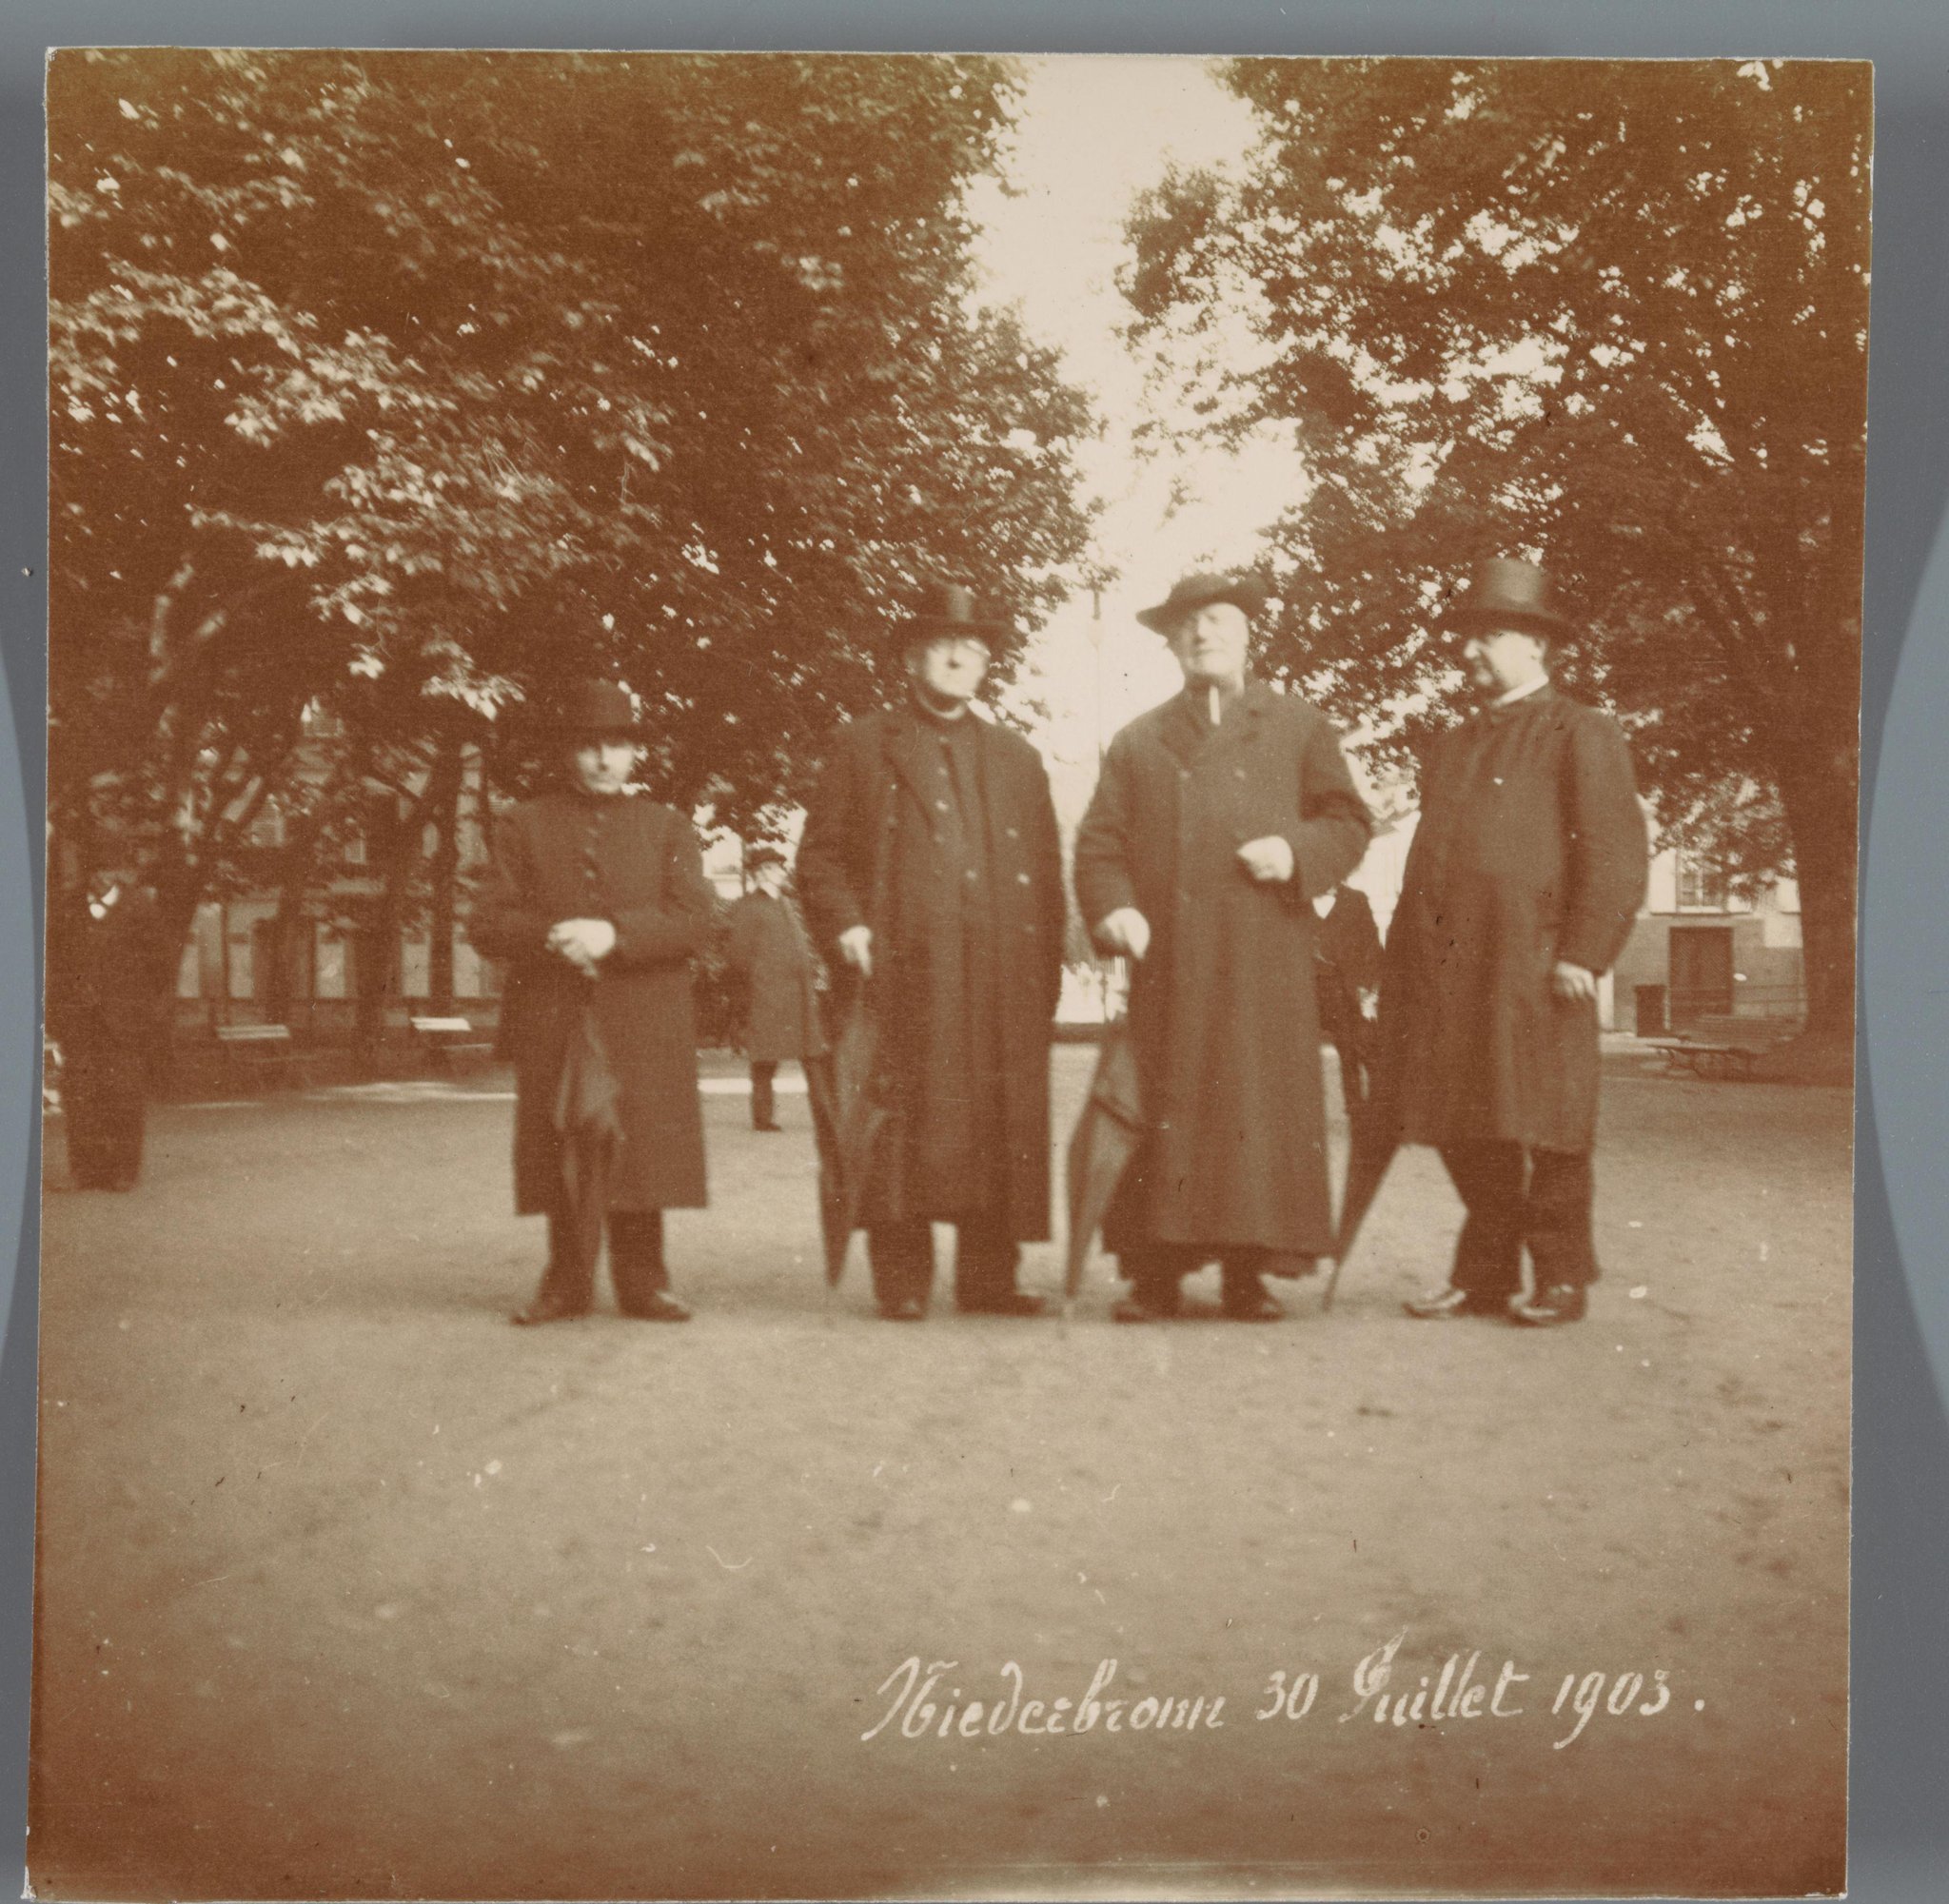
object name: photograph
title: Vier mannen op straat, Niederbronn (Bas-Rhin), Frankrijk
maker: Anonymous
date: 1903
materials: paper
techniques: gelatin silver print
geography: france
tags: public road in village (+ city(-scape) with figures, staffage), france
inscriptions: annotation: ‘Niederbronn 30 Juillet 1903’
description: Vier mannen op straat, Niederbronn (Bas-Rhin), Frankrijk.